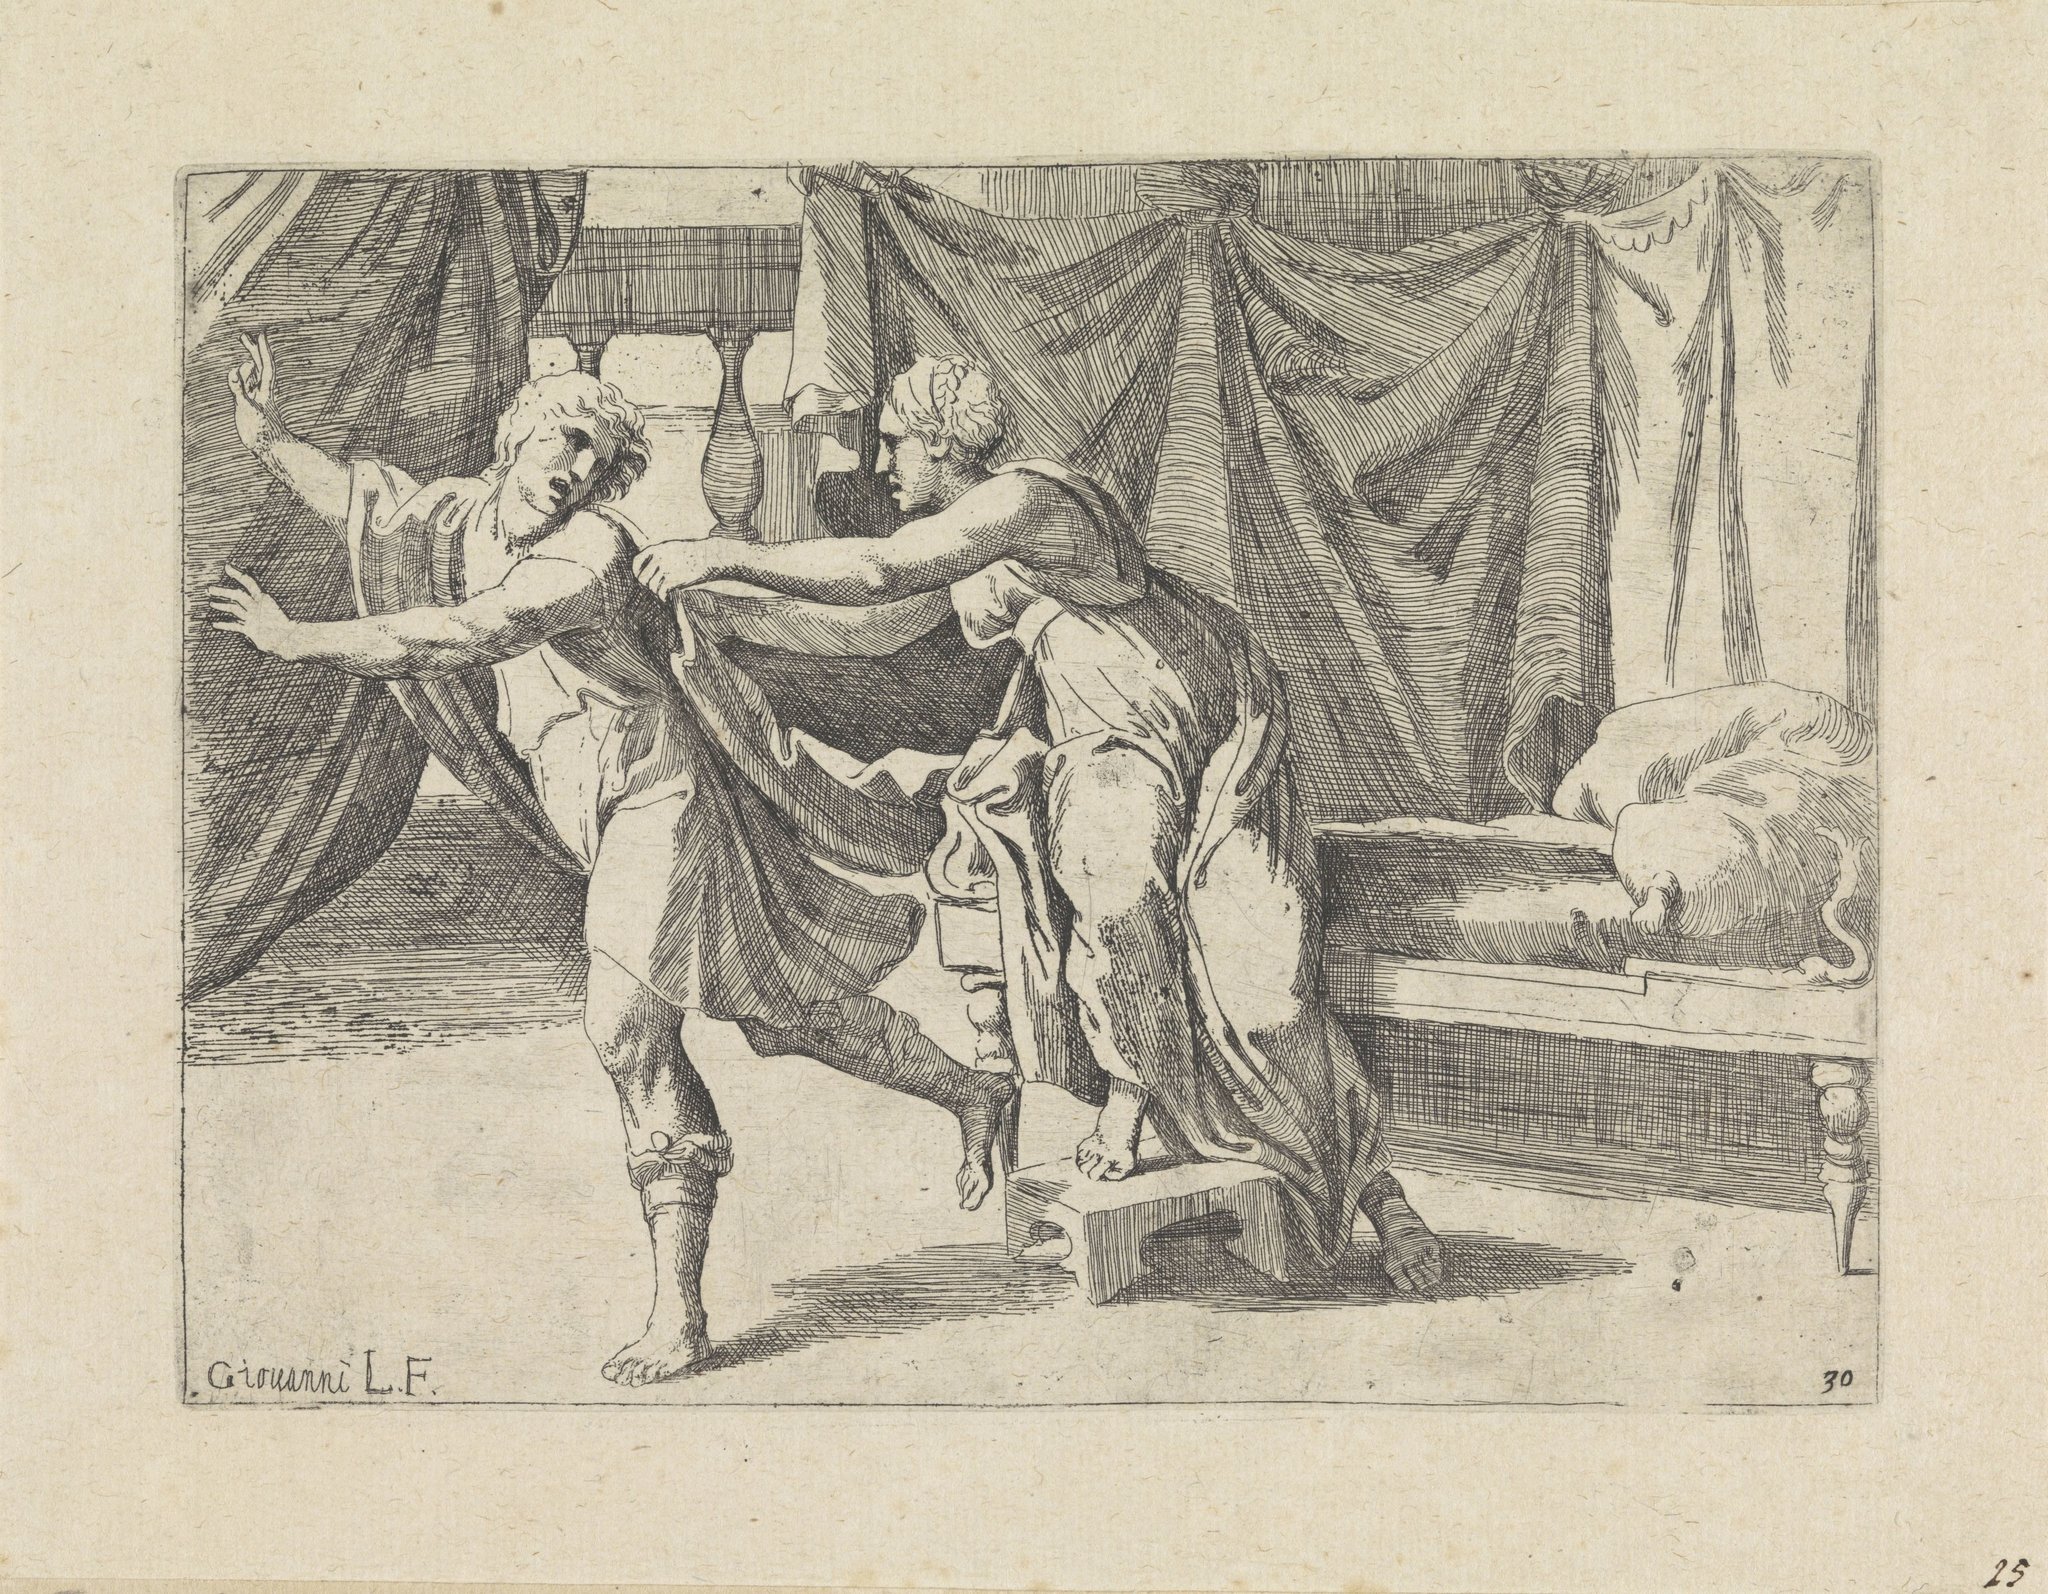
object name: print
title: Jozef en de vrouw van Potifar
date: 1607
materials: paper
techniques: etching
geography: italy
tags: potiphar's wife catches joseph by his robe, usually while lying in bed; joseph escapes leaving his cloak behind in her hands (possibly with a naked child lying in a crib)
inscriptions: collector's mark: Lugt 11, collector's mark: ‘Hinloopen’, number: ‘25’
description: Op een blad geplakt met rechtsboven handgeschreven in pen in bruin: 145. Prent uit een reeks van 54 genummerde prenten naar schilderingen in de Loggia van Rafael in het Vaticaan.